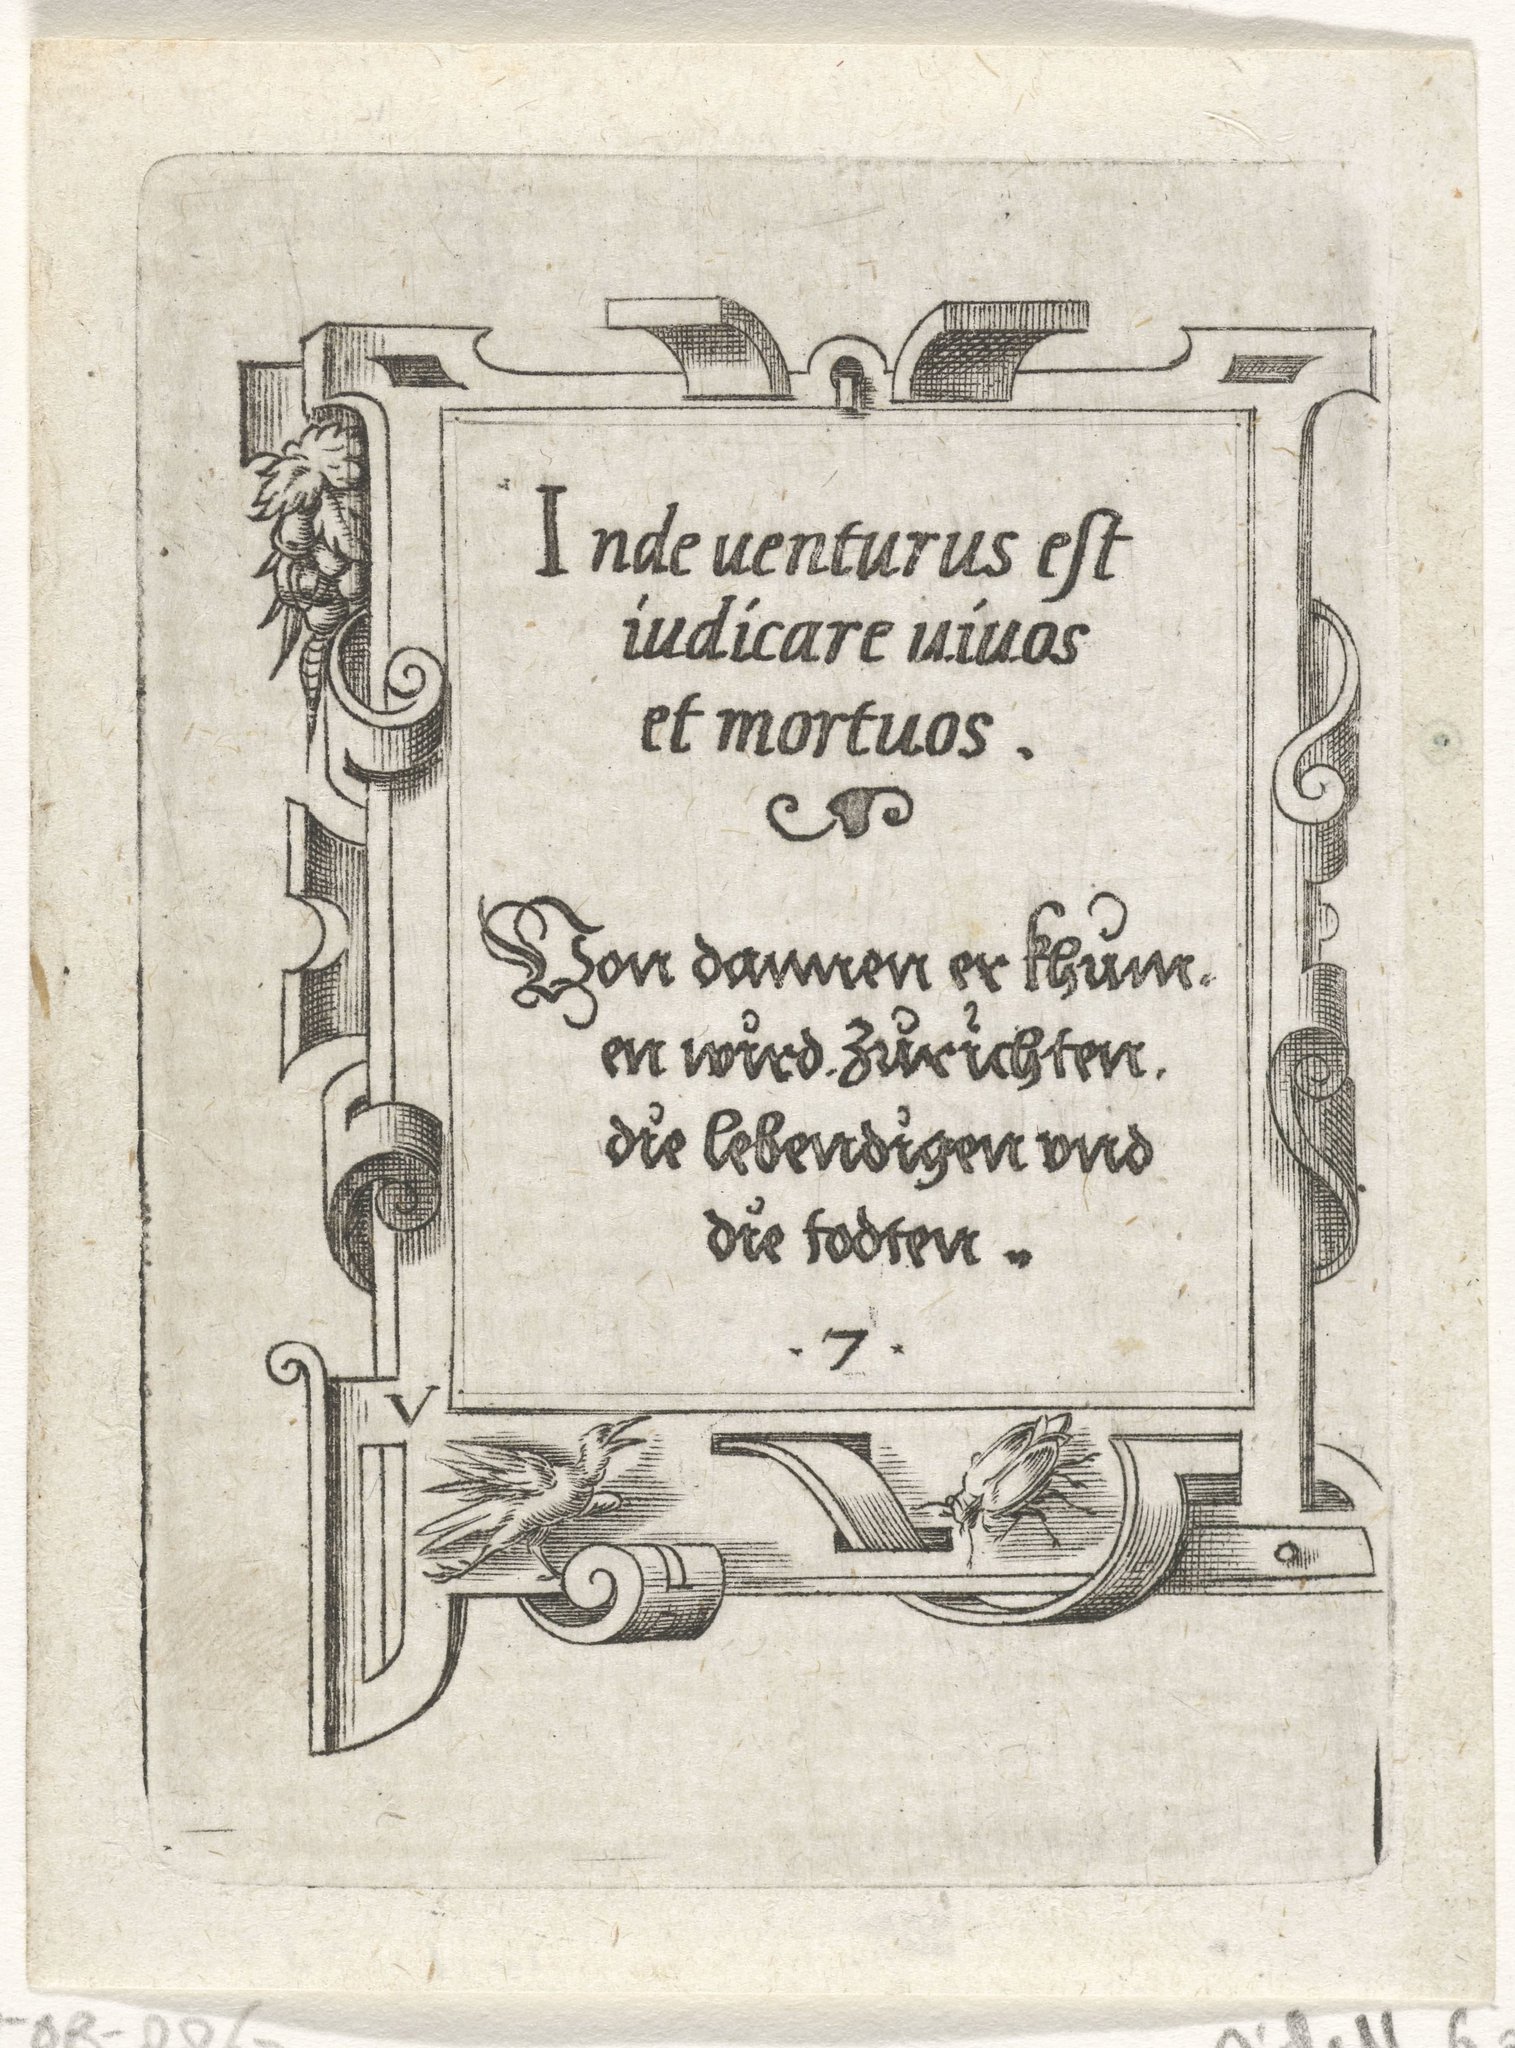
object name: print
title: Tekst: Indeuenturus est...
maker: virgilius solis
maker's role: draughtsman, print maker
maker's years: 1514-1562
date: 1524-1562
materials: paper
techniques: engraving